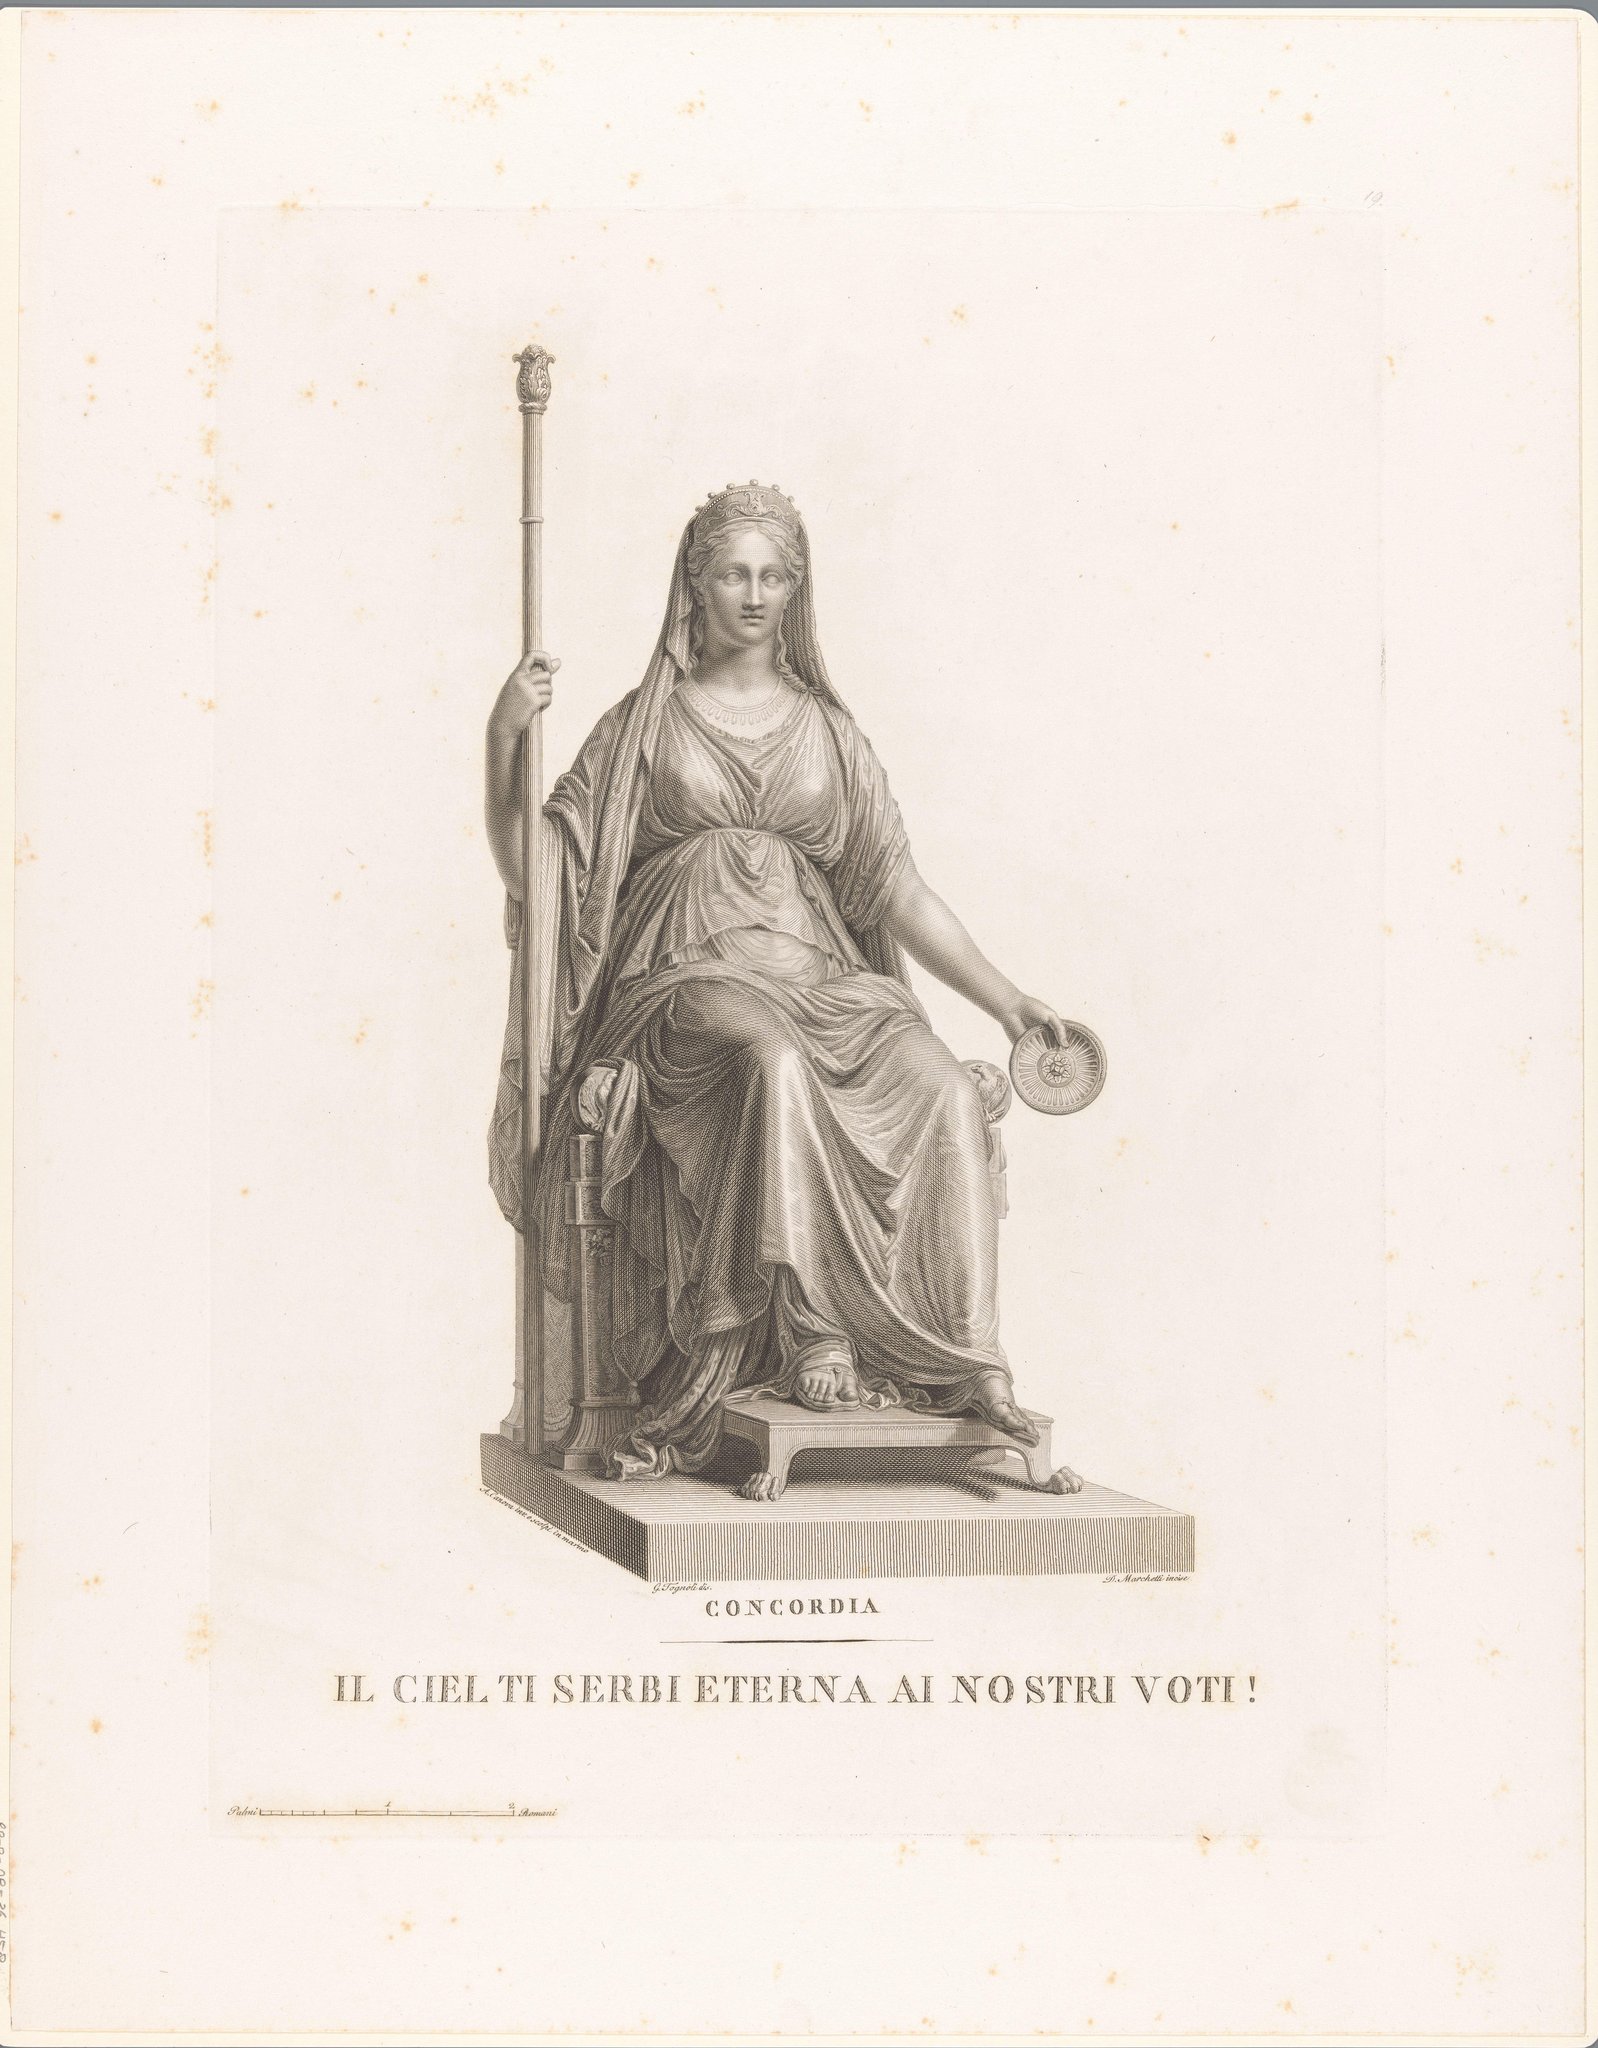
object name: print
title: Concordia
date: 1790-1844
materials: paper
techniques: engraving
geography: italy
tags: concordia as roman personification, piece of sculpture, reproduction of a piece of sculpture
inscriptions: collector's mark: Lugt 12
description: Deze prent maakt deel uit van een reeks van onbekende omvang met voorstellingen van sculpturen van Antonio Canova door verschillende prentmakers naar tekeningen van Giovanni Tognolli.